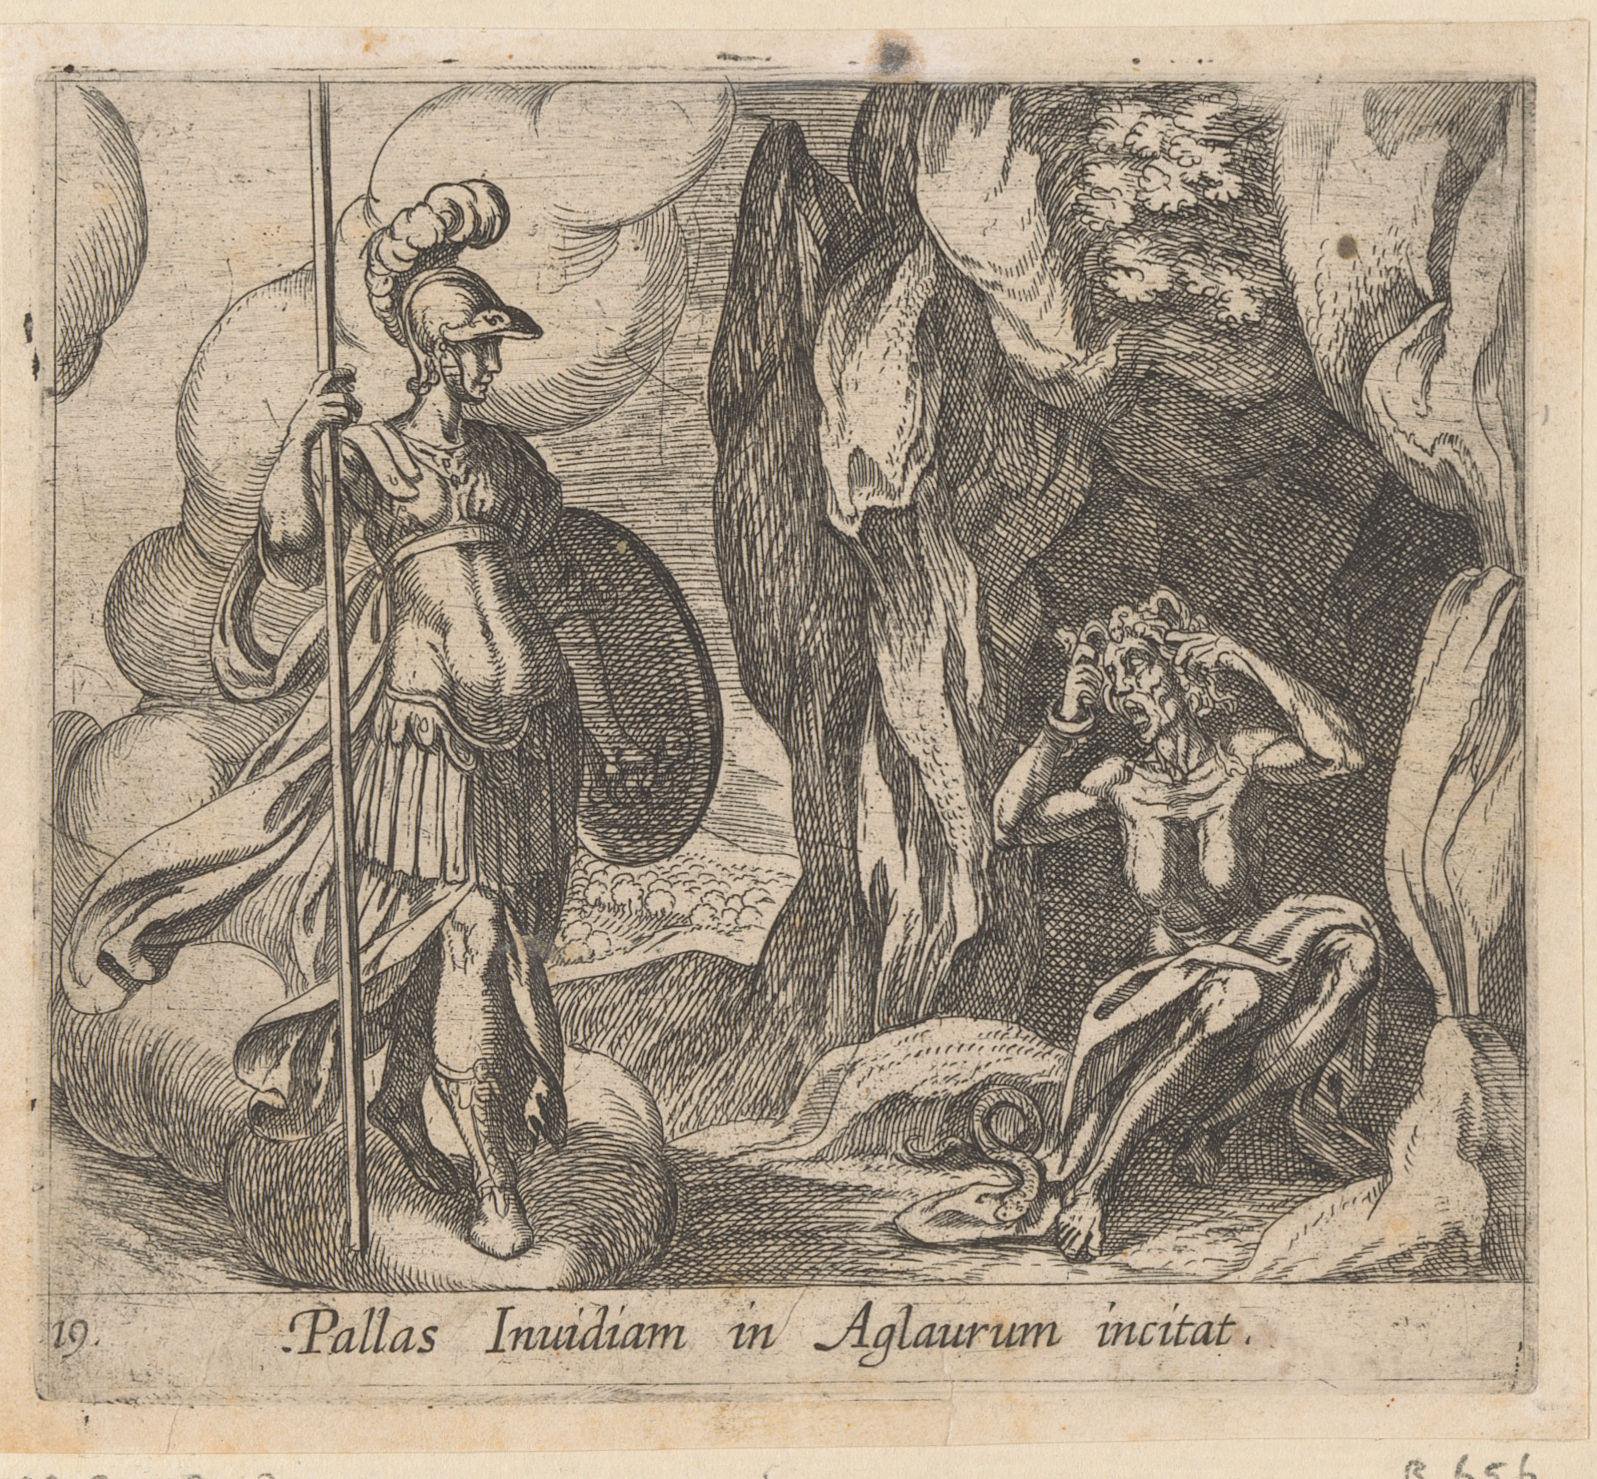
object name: print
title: Metamorfosen van Ovidius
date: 1606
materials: paper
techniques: etching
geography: italy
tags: minerva visits the cave of envy (invidia) in order to punish aglauros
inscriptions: collector's mark: Lugt 240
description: De godin Minerva staat voor de grot met een naakte oude vrouw met slangen als haren (Nijd). Titel in het Latijn in ondermarge.